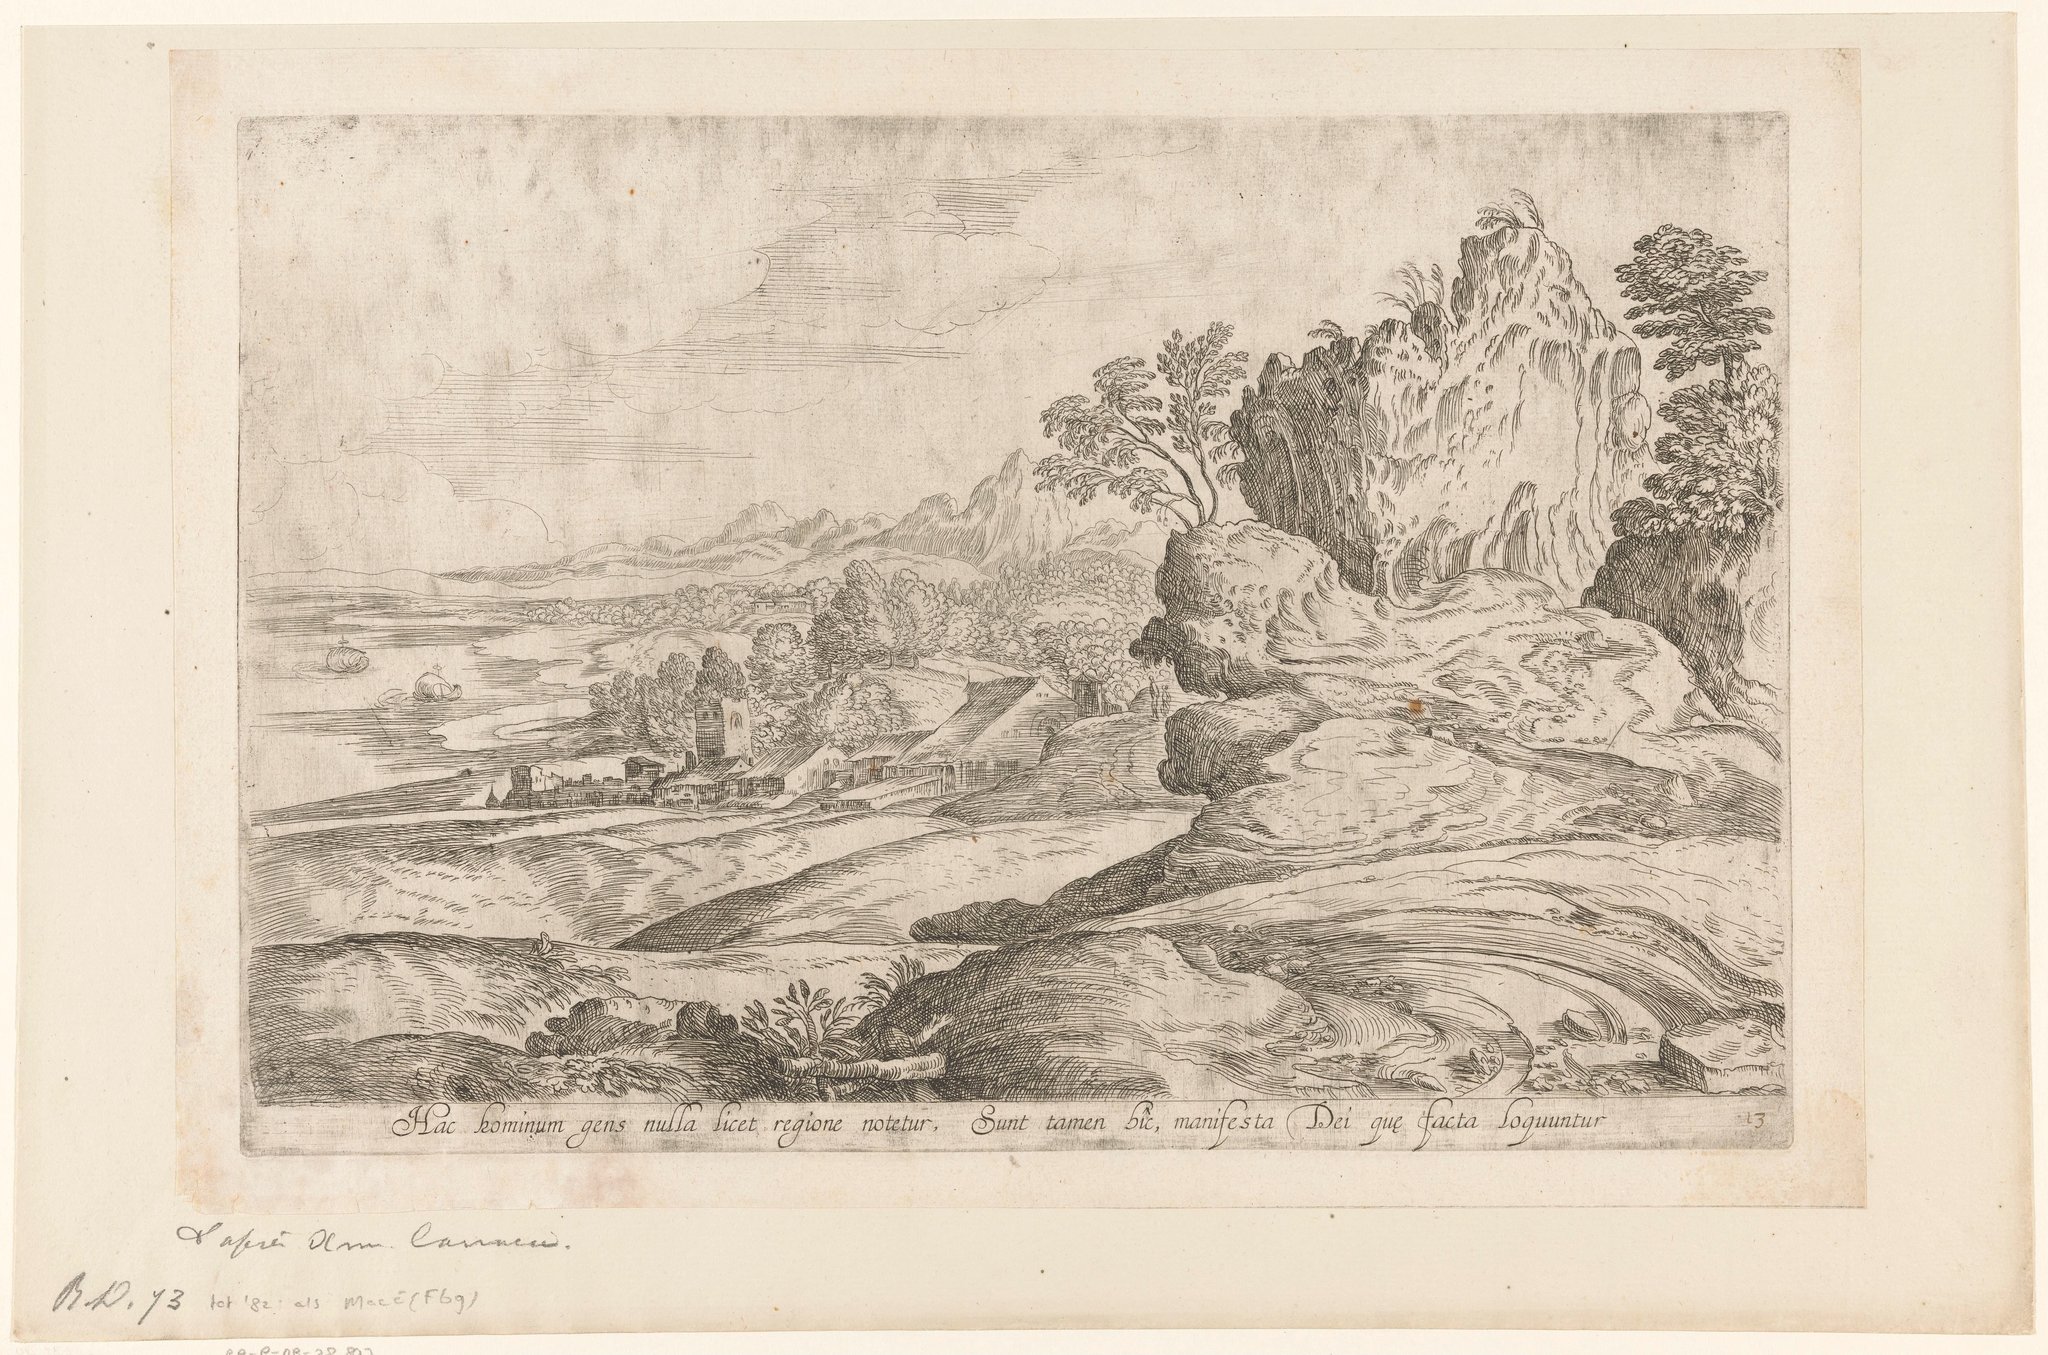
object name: print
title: Landschap met bebouwing aan de waterkant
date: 1600-1699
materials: paper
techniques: etching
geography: italy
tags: landscapes, coast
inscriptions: collector's mark: Lugt 2228, number: ‘13’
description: Kustlandschap met enkele woningen aan de waterkant. Landinwaarts heuvels. Titel in het Latijn in ondermarge.